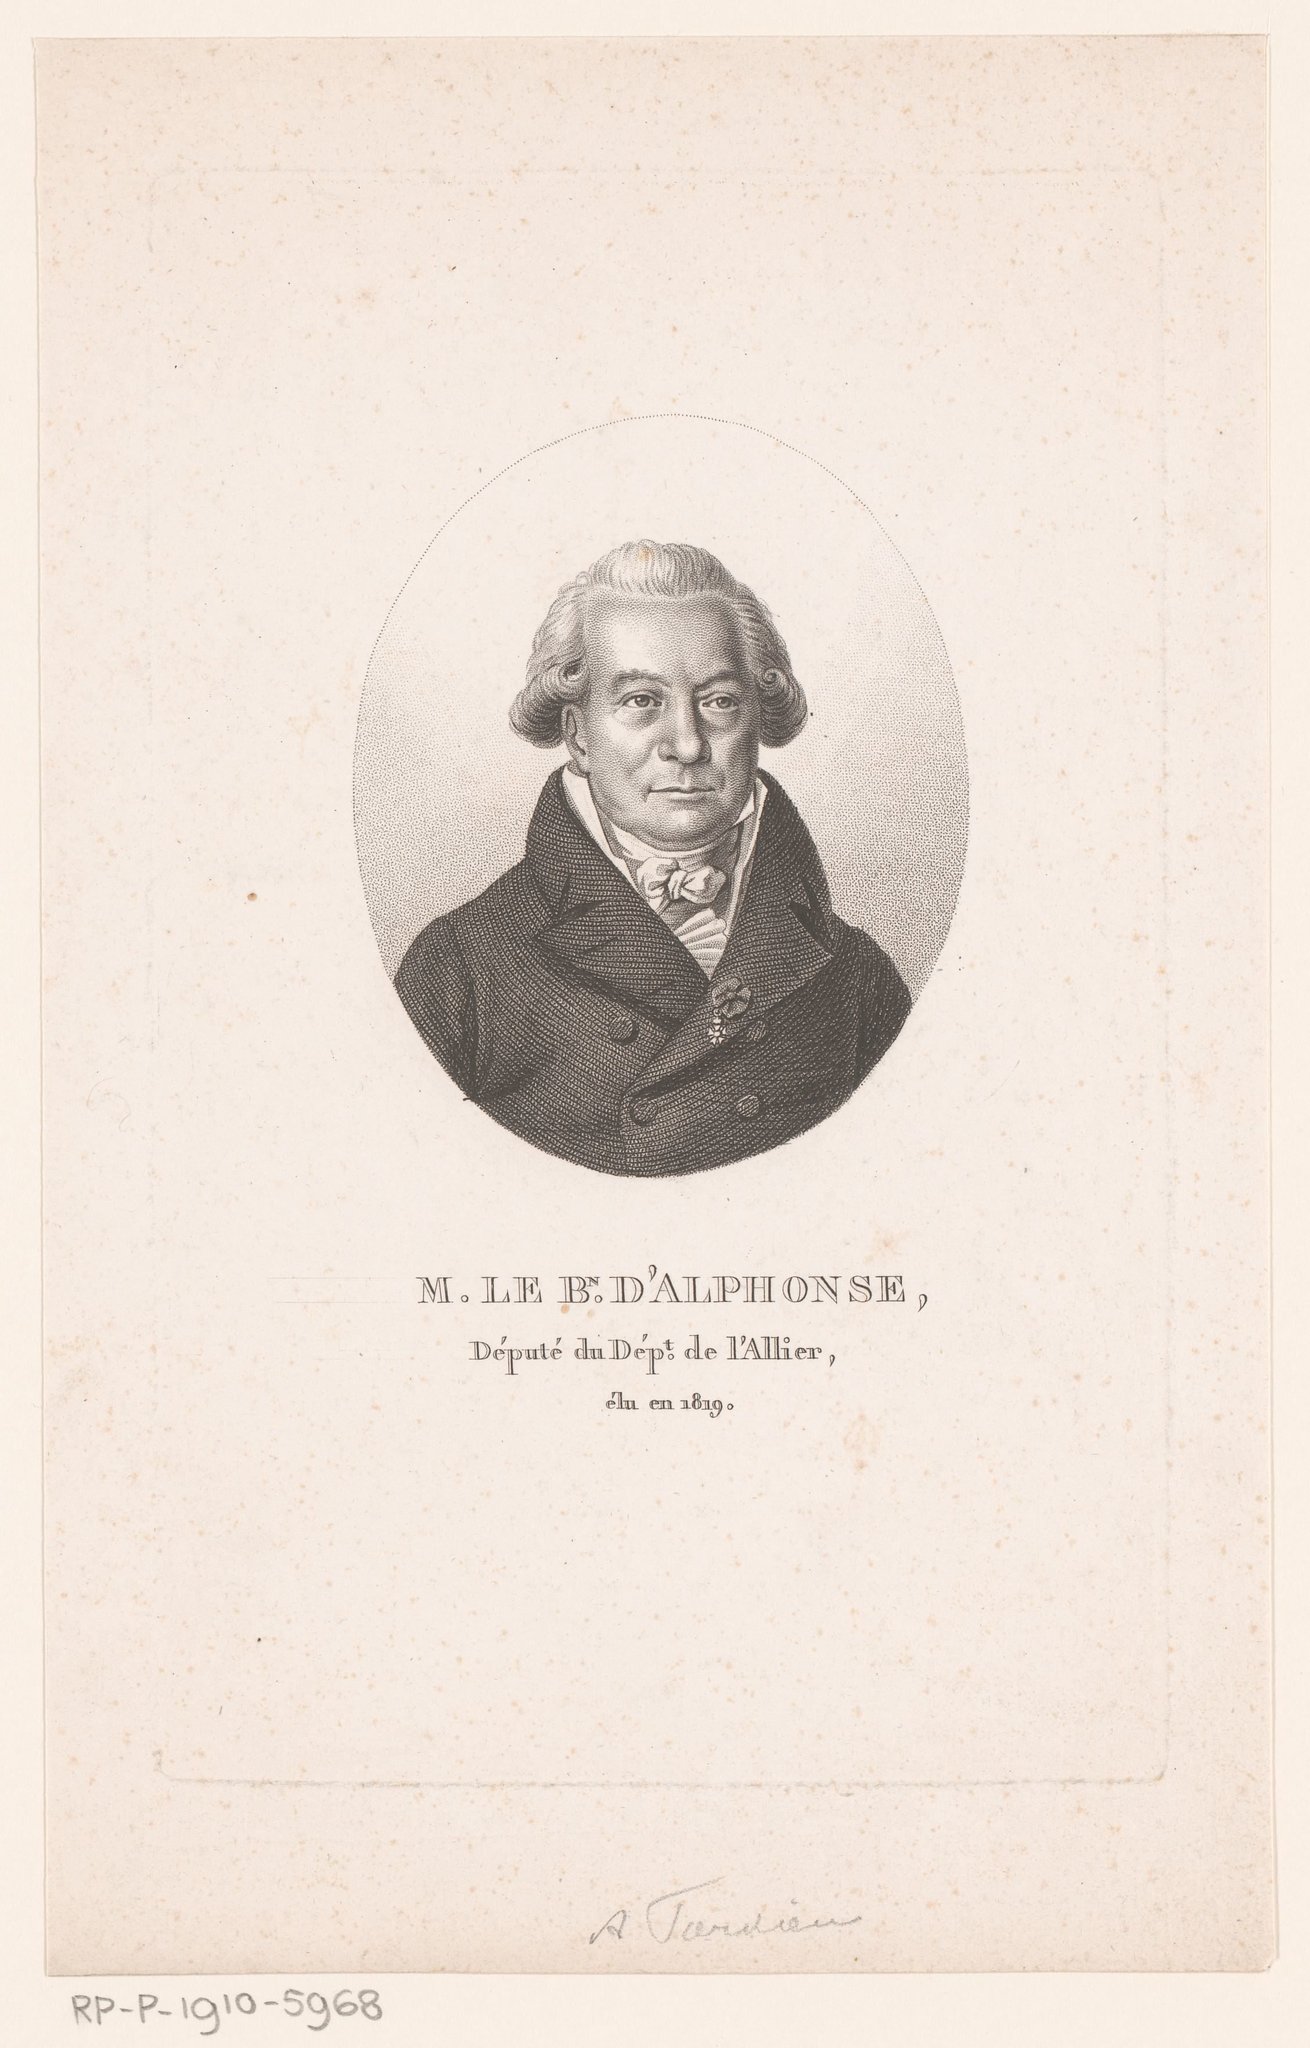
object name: book illustration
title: Portret van François Dalphonse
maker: ambroise tardieu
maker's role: print maker, printer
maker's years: 1788-1841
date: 1820-1821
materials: paper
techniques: engraving, roulette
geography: paris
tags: politician, historical persons, politician, e.g. party leader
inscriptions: collector's mark: Lugt 2228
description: Prent uit: Tardieu, Ambroise. Portraits des députés, écrivains et pairs constitutionnels, défenseurs invariables de la charte et de la loi des élections du 5 février 1817. Parijs: Tardieu, Ambroise, 1820-1821.